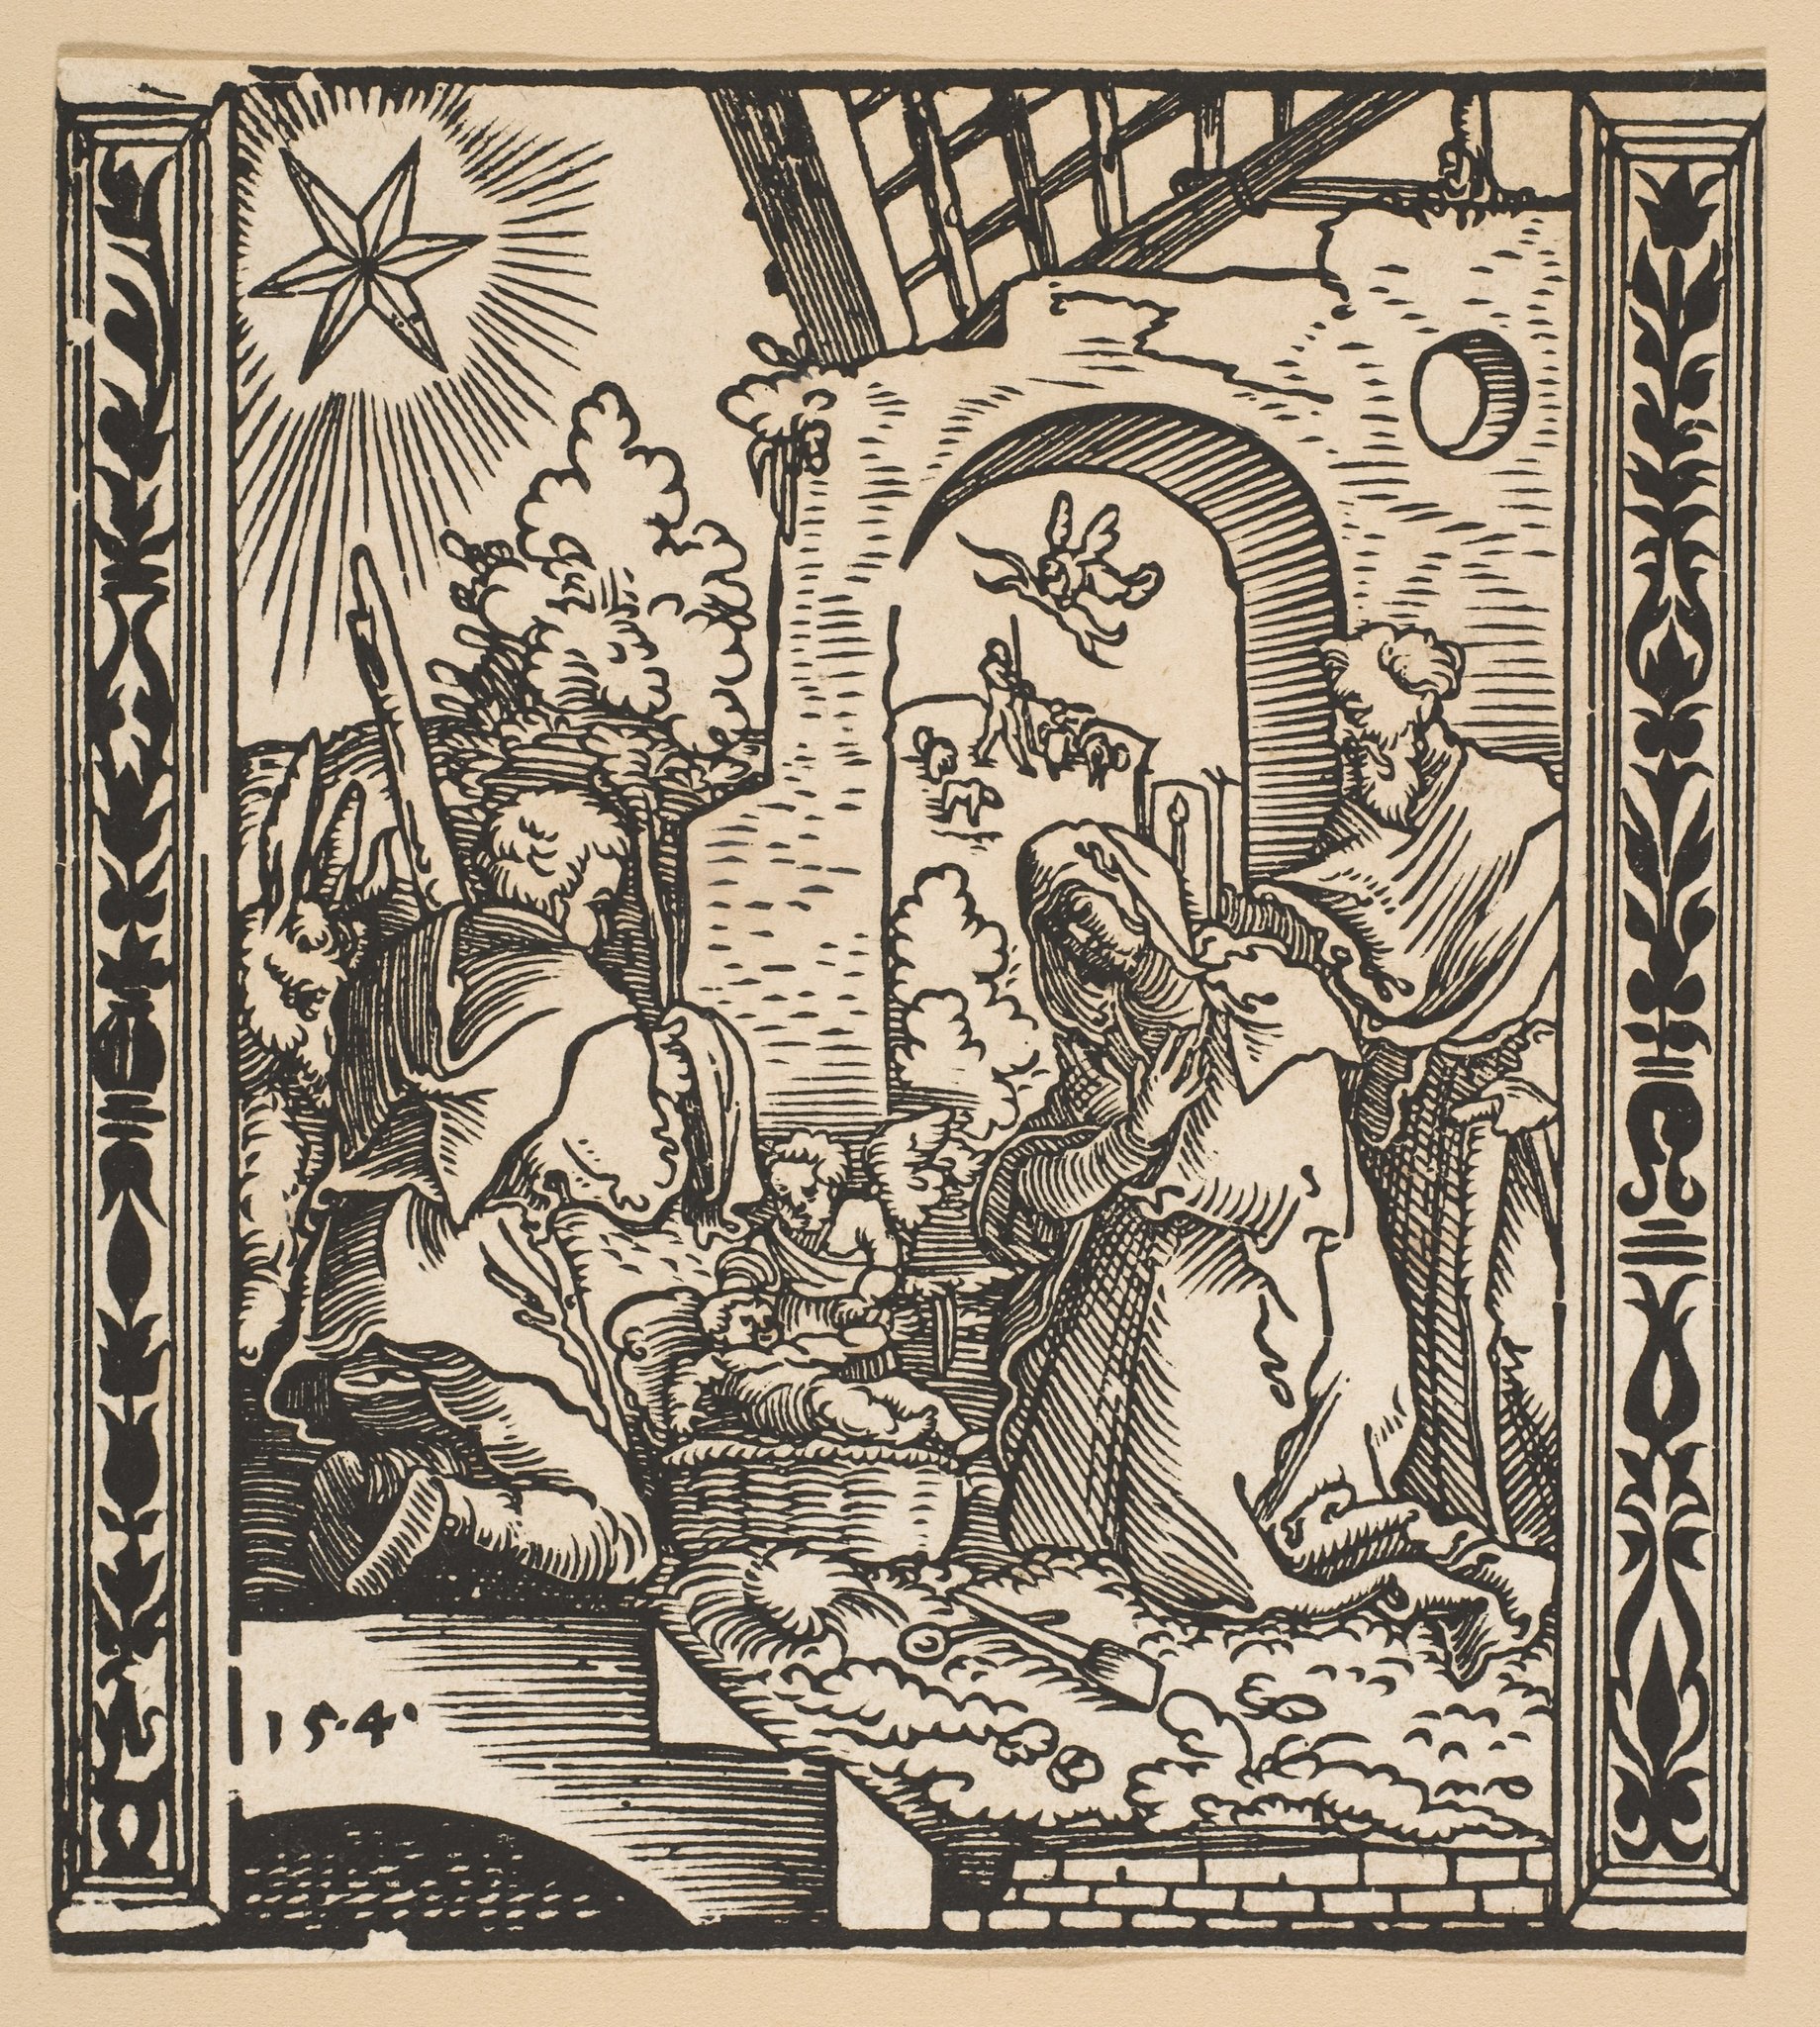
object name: print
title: The Nativity (copy)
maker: albrecht dürer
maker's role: artist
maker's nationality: german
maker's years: 1471-1528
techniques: woodcut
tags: christ,virgin mary,nativity